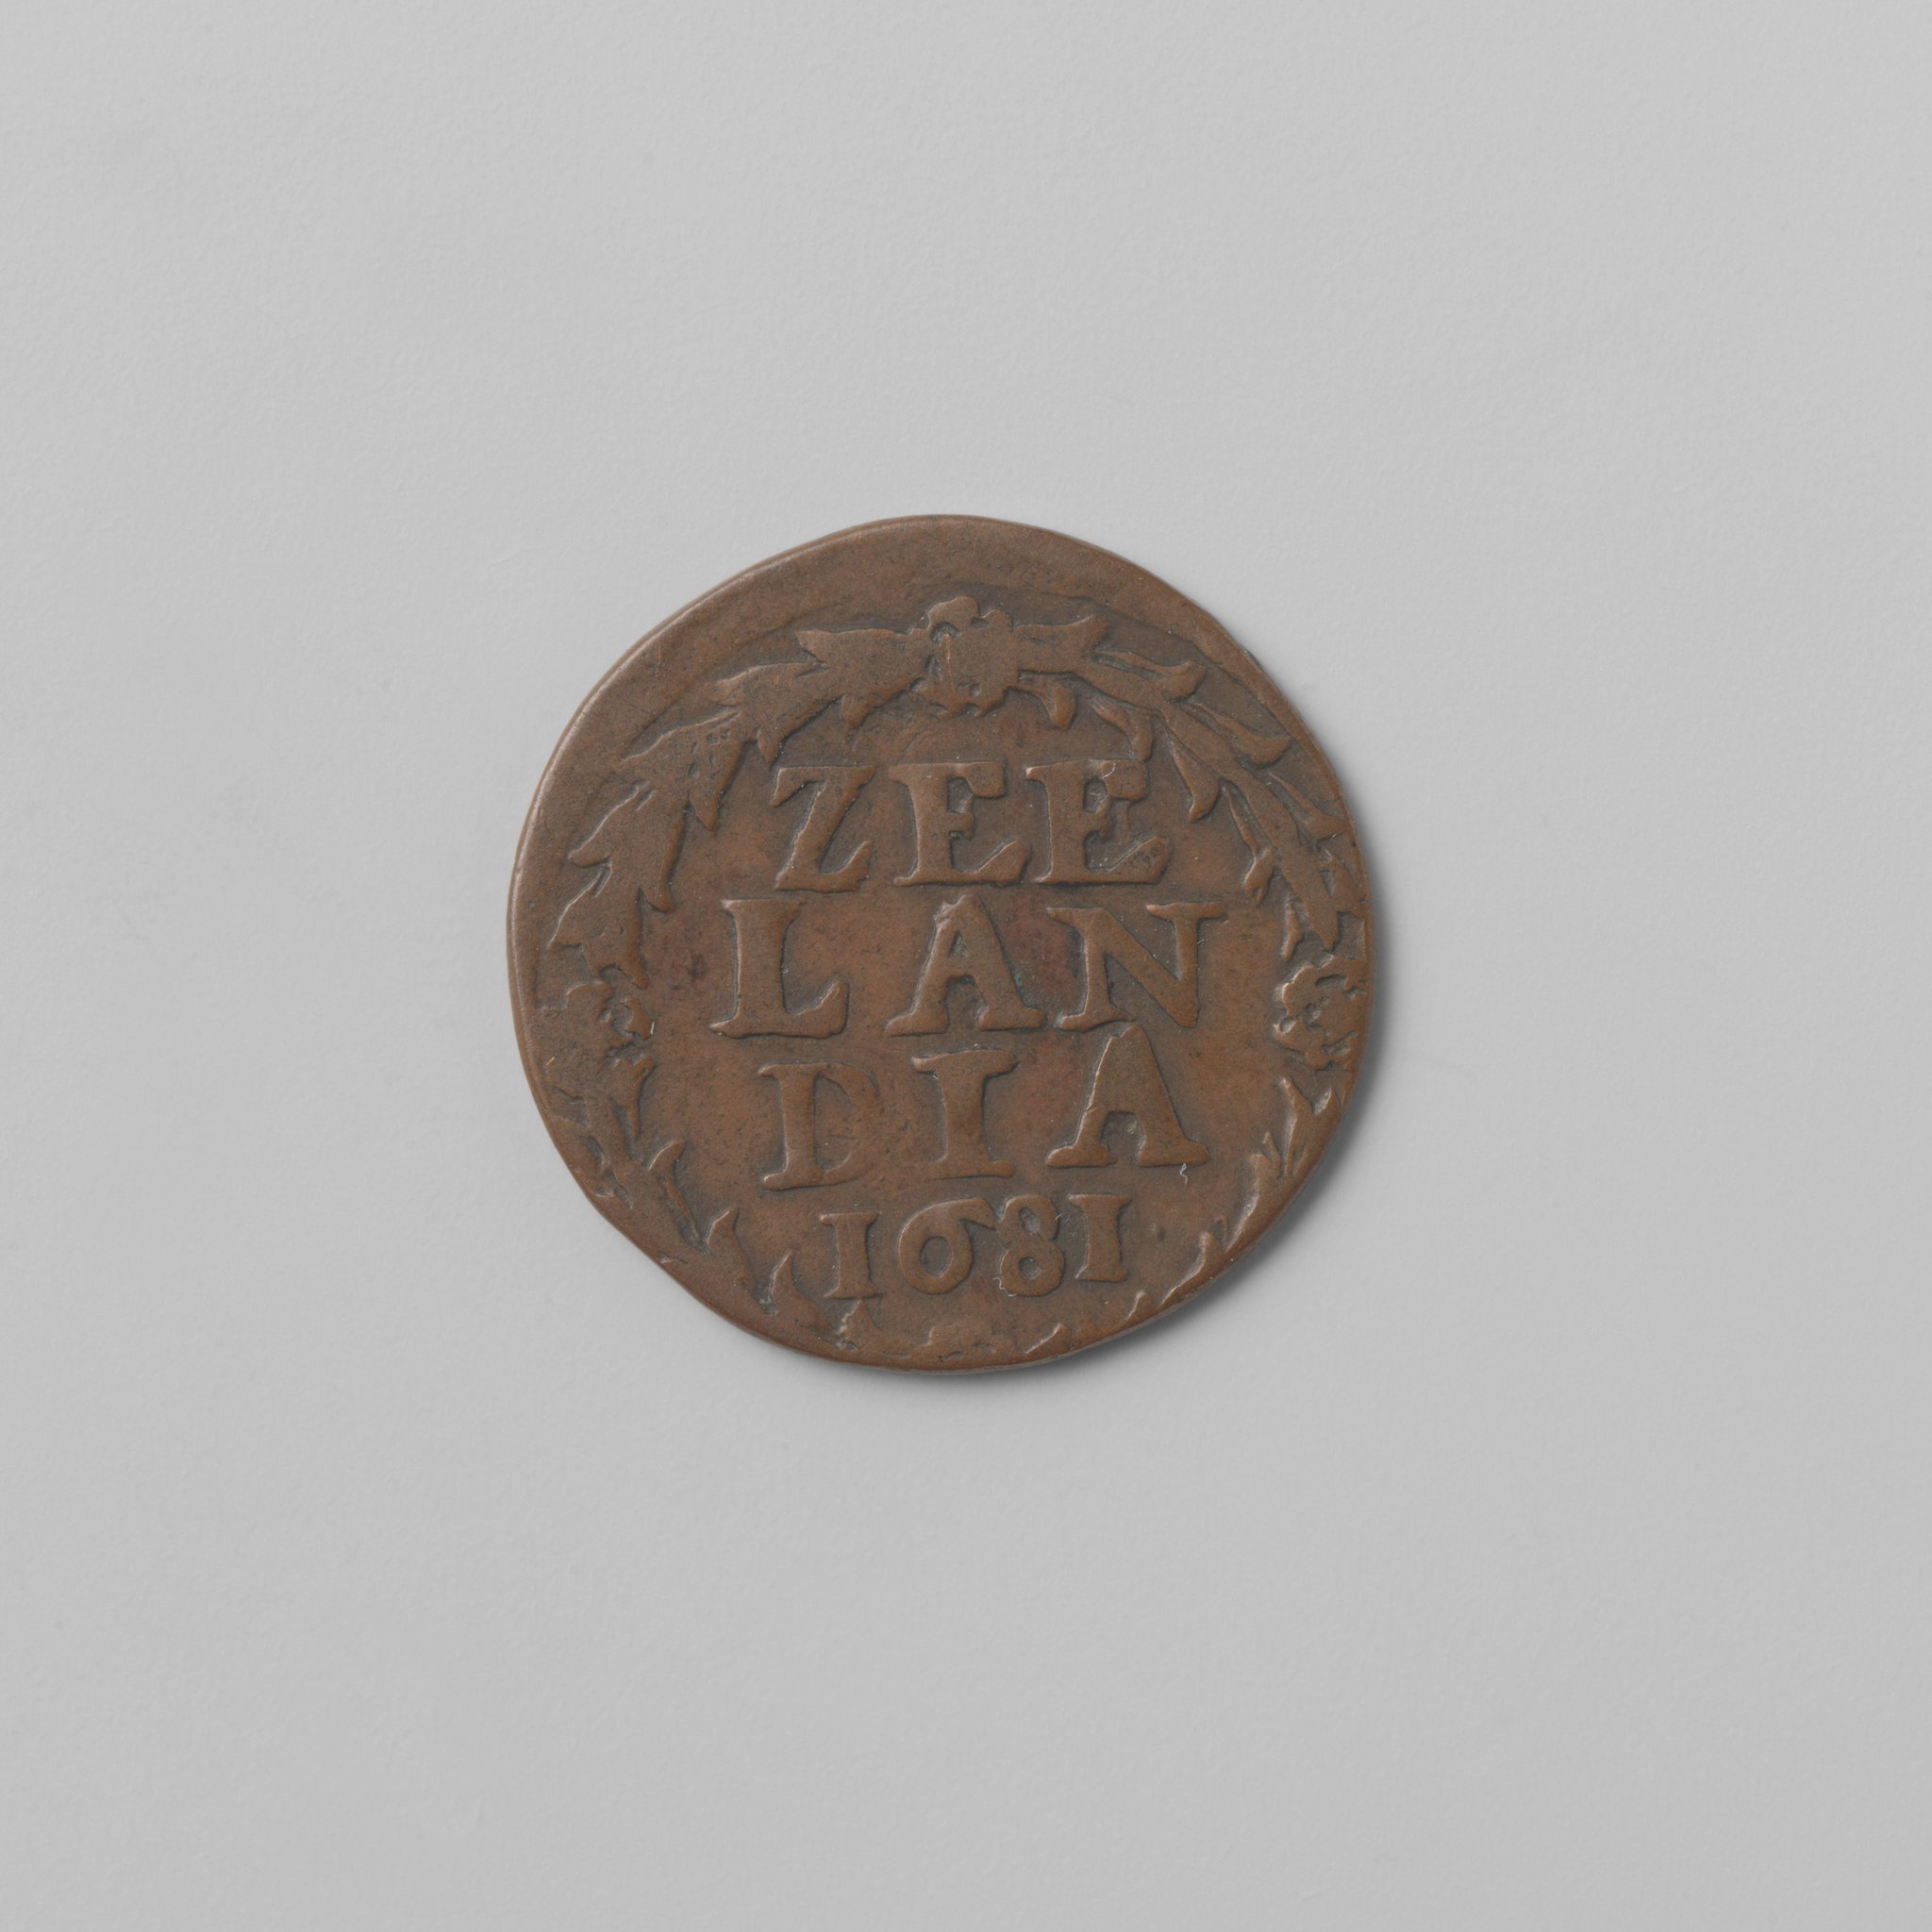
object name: coin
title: Zeeuwse duit, 1681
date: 1681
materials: copper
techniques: striking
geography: middelburg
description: Koperen munt. Voorzijde: maagd zittend achter wapenschild van Zeeland in eeen tuin met gesloten omheining. Keerzijde: binnen bladerkrans opschrift in drie regels, waaronder jaartal.